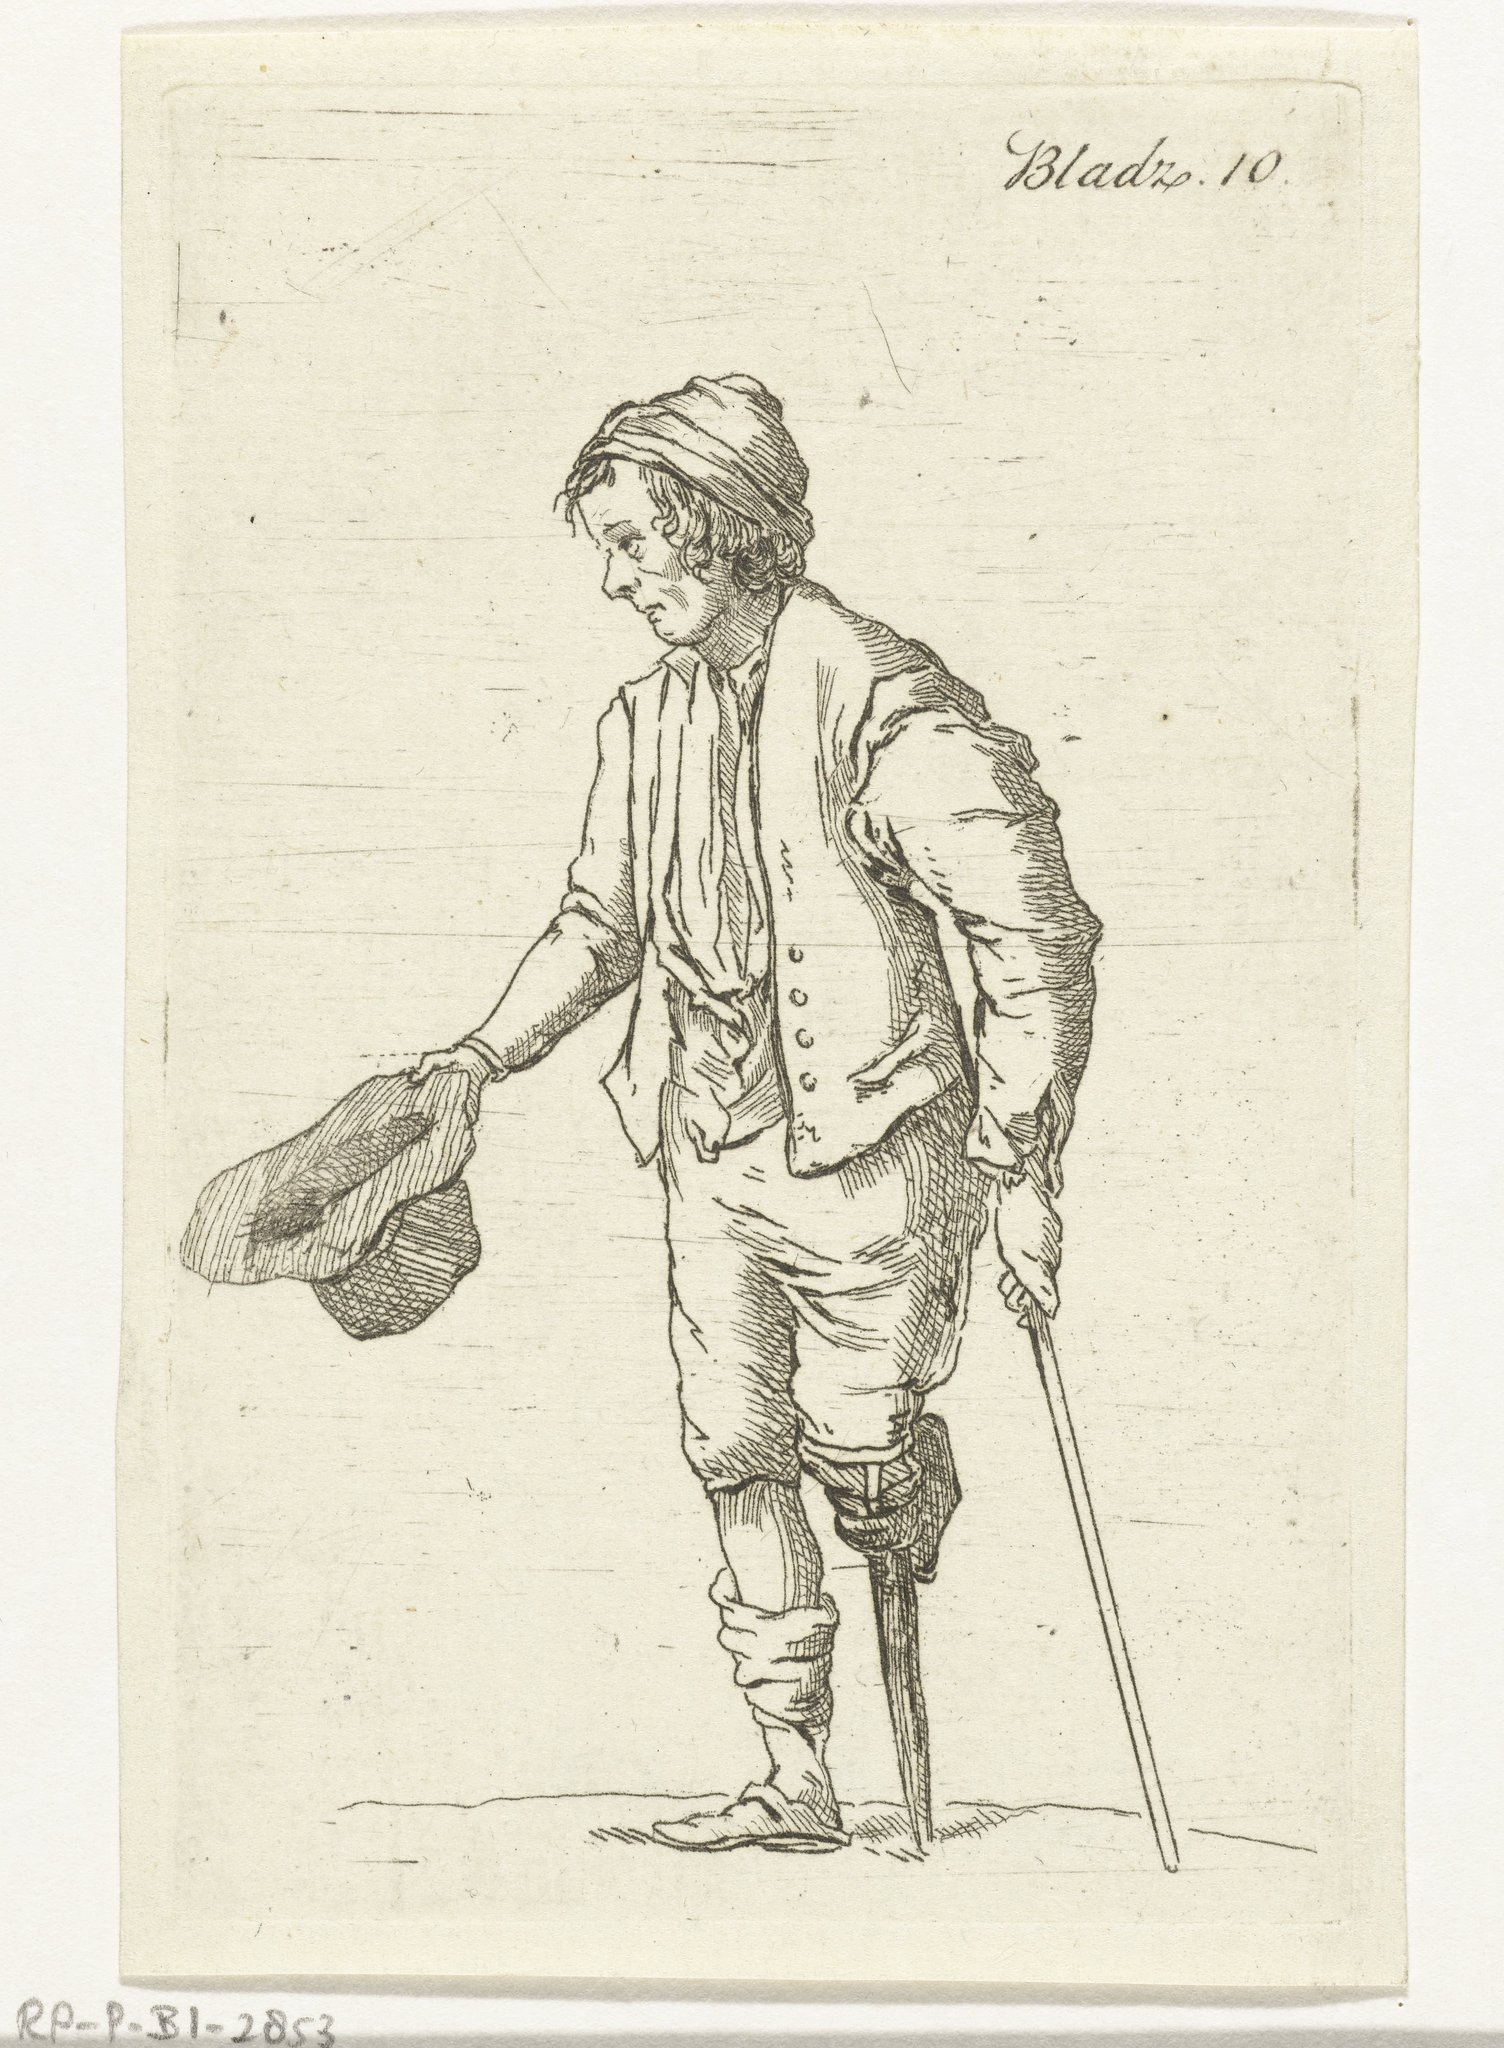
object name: print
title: Staande figuren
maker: anthonie van den bos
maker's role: draughtsman, print maker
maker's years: 1763-1838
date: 1778-1838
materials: paper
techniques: etching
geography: netherlands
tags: standing figure (canon, proportions), beggar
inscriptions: collector's mark: Lugt 2228